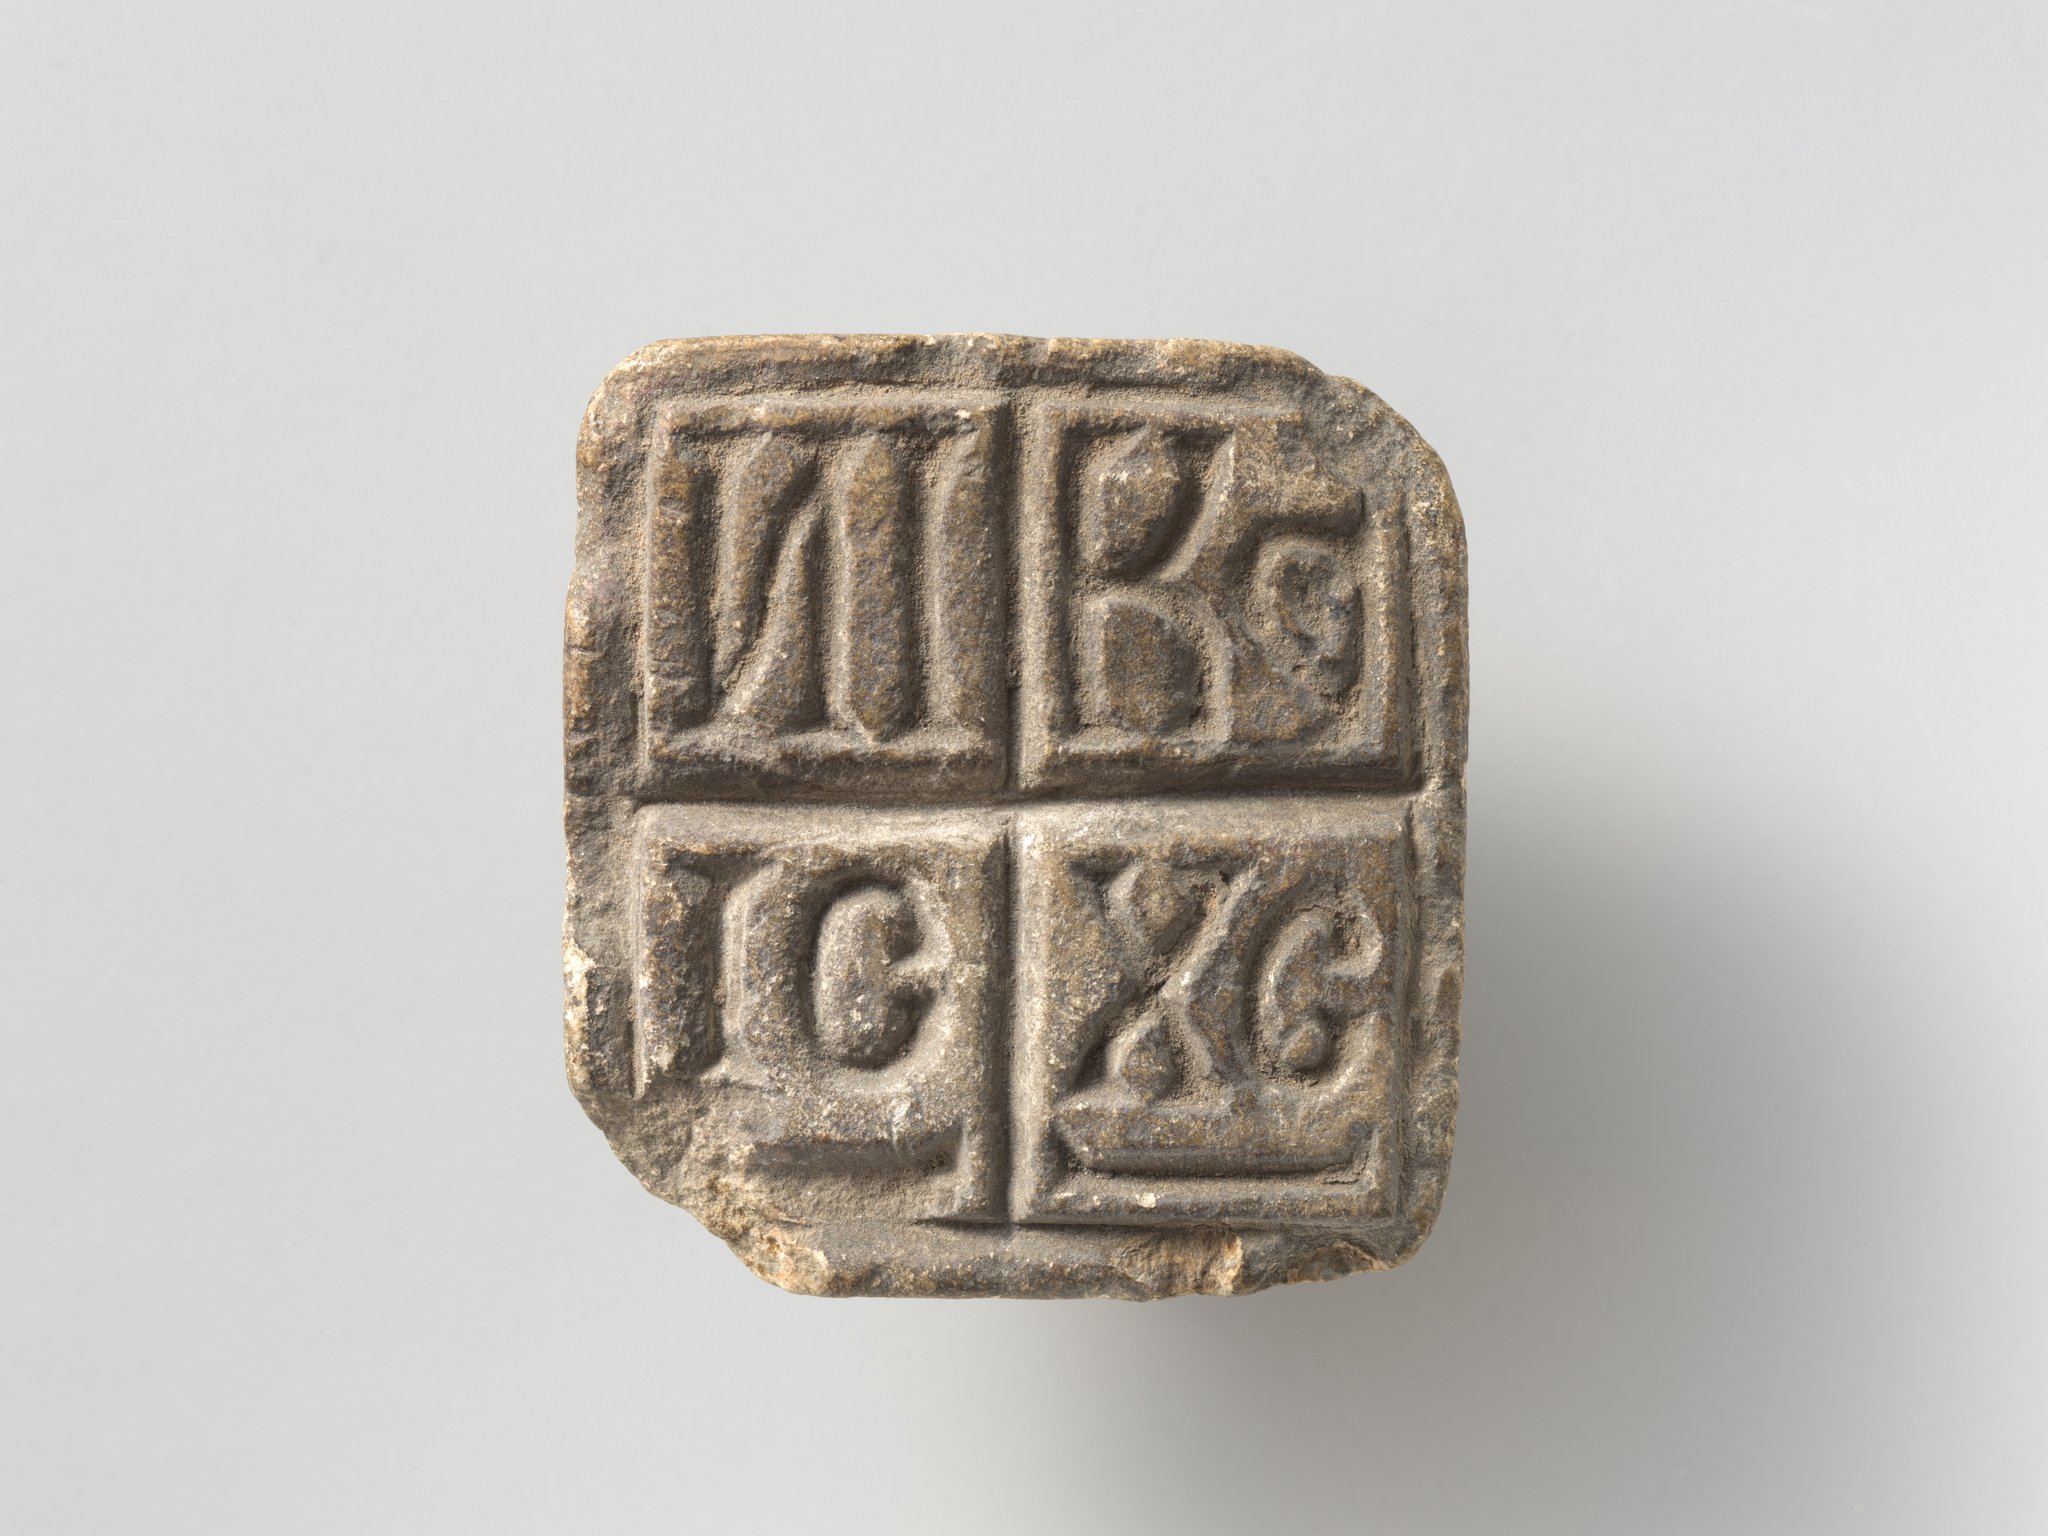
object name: stamp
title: Bread Stamp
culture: byzantine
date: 500-900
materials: ceramic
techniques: firing